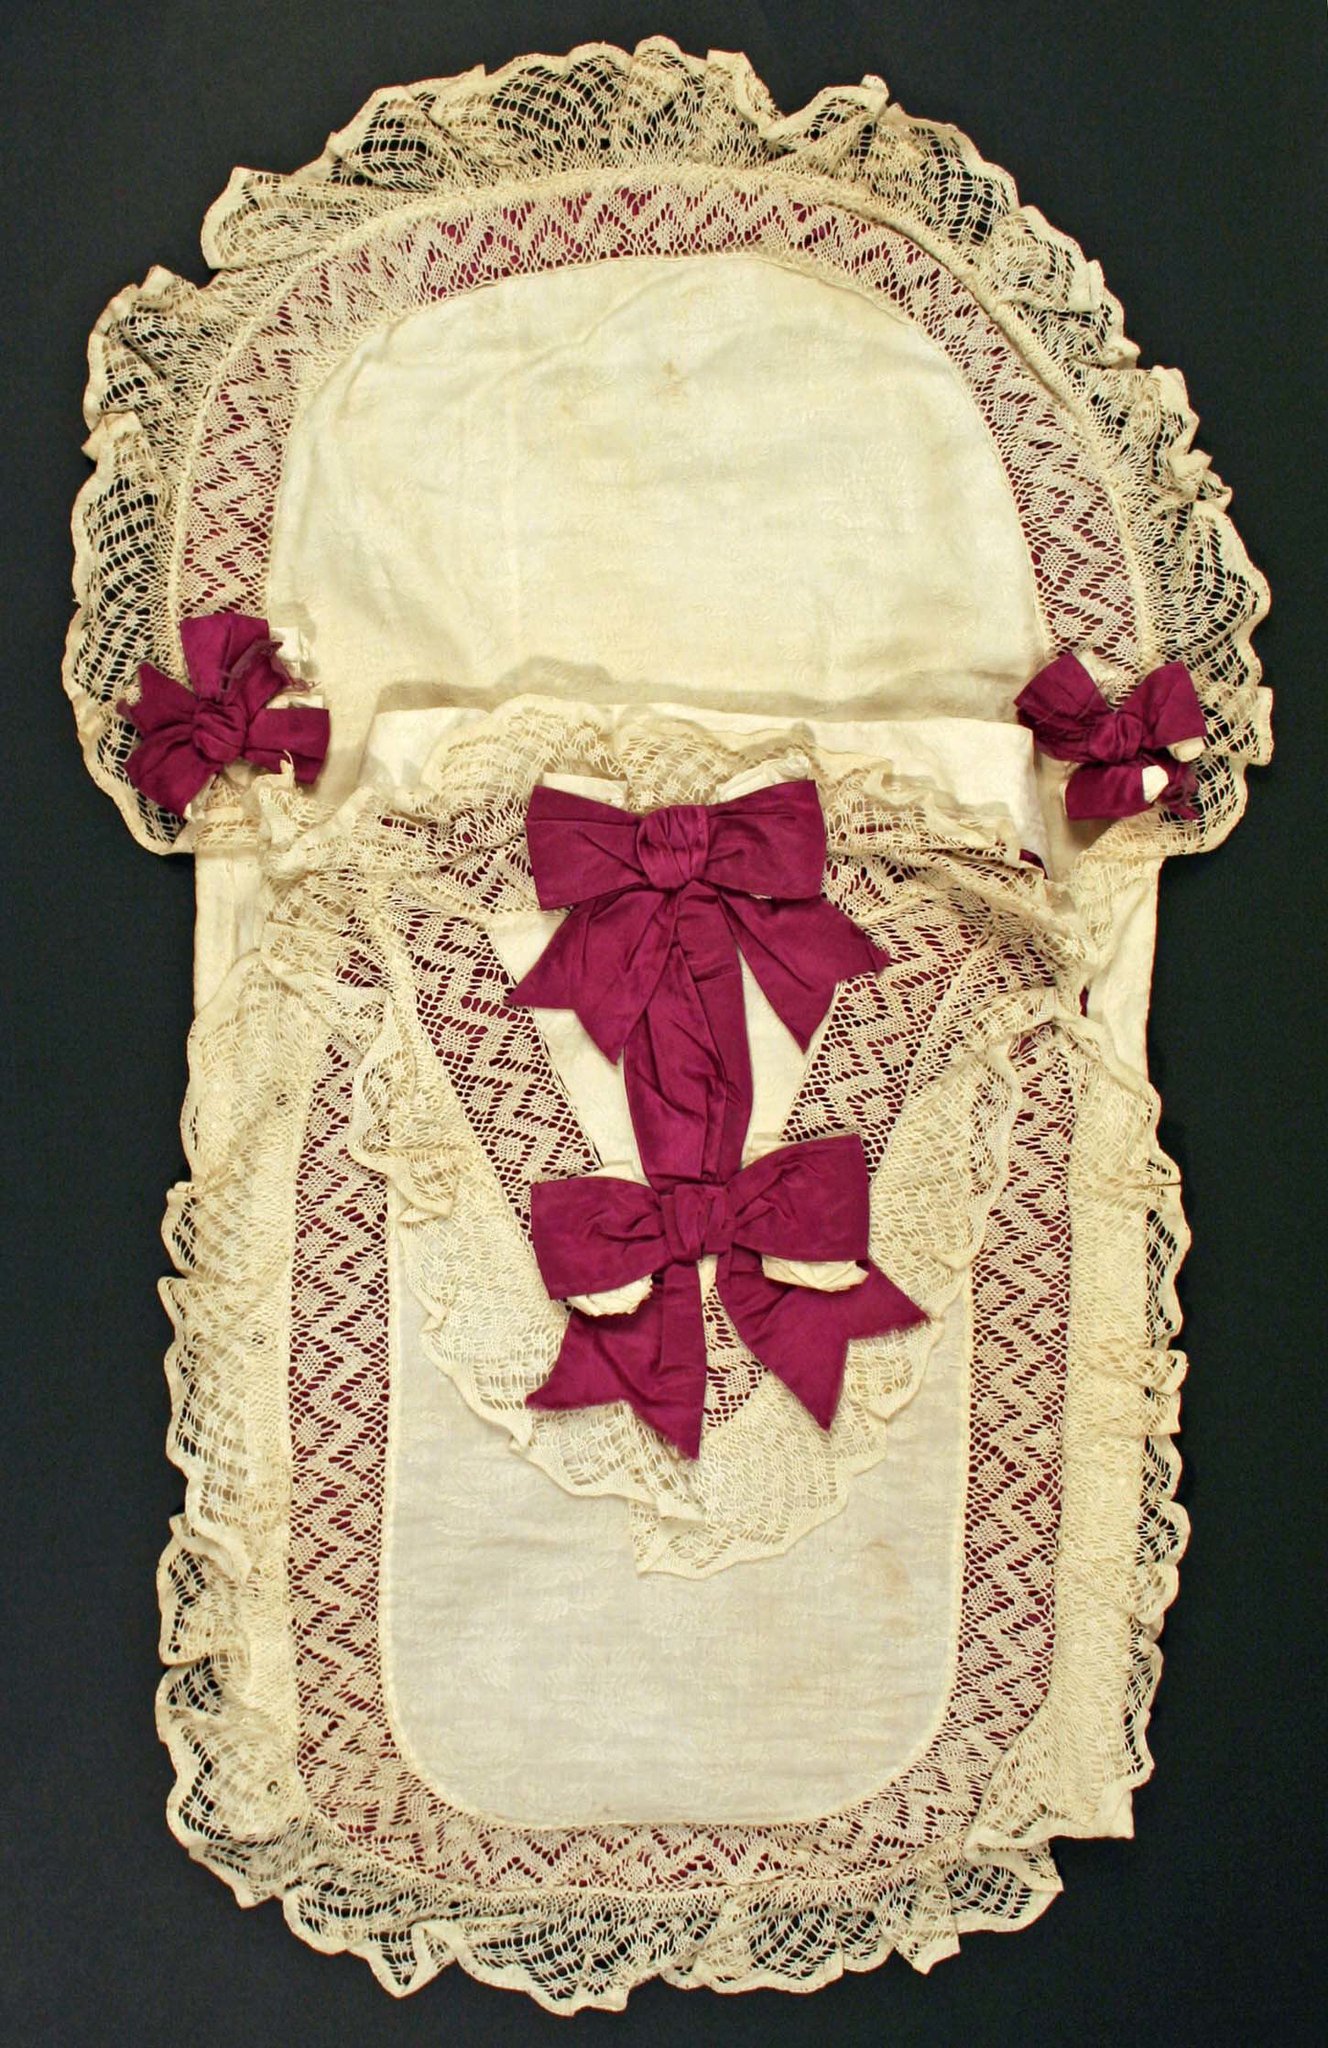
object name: layette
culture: american or european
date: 1882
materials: cotton